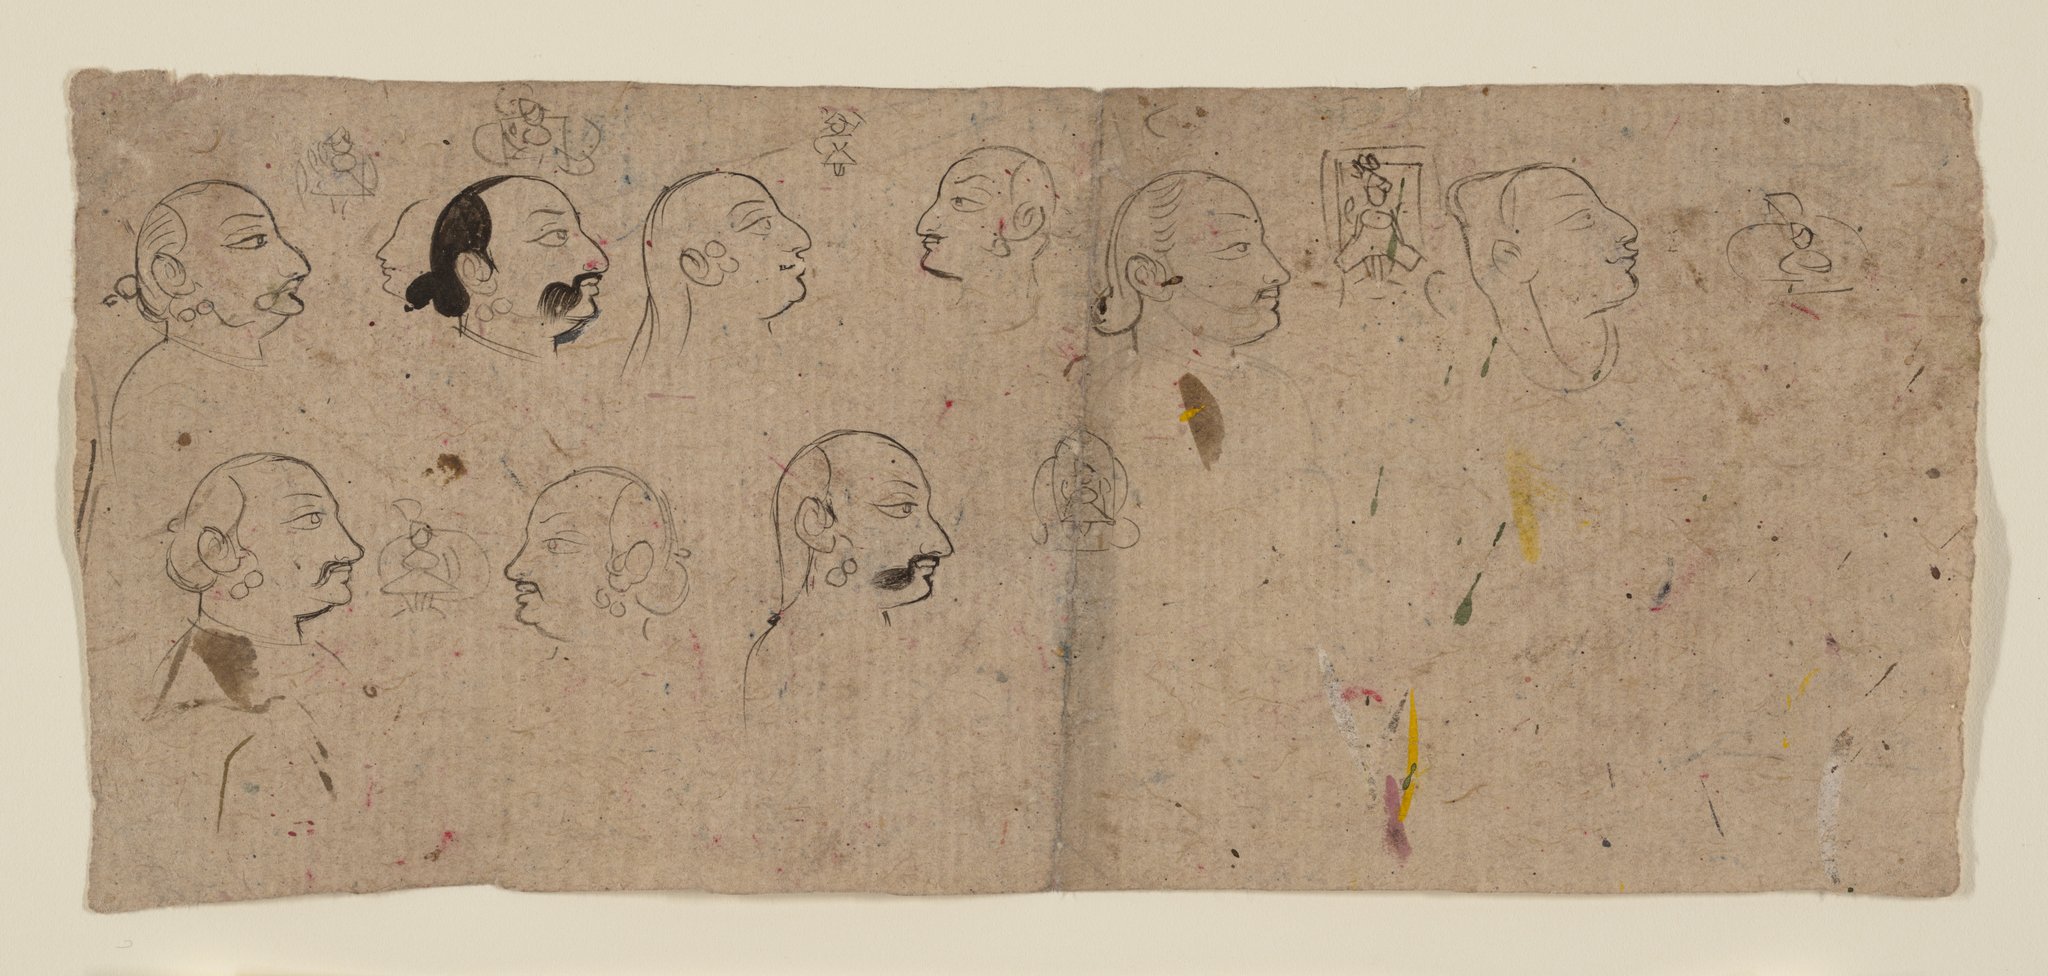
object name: painting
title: Sketch Page of Facial Studies, likely Maharao Kishor Singh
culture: indian or rajasthan or kotah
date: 1830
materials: ink, paper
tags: heads,men